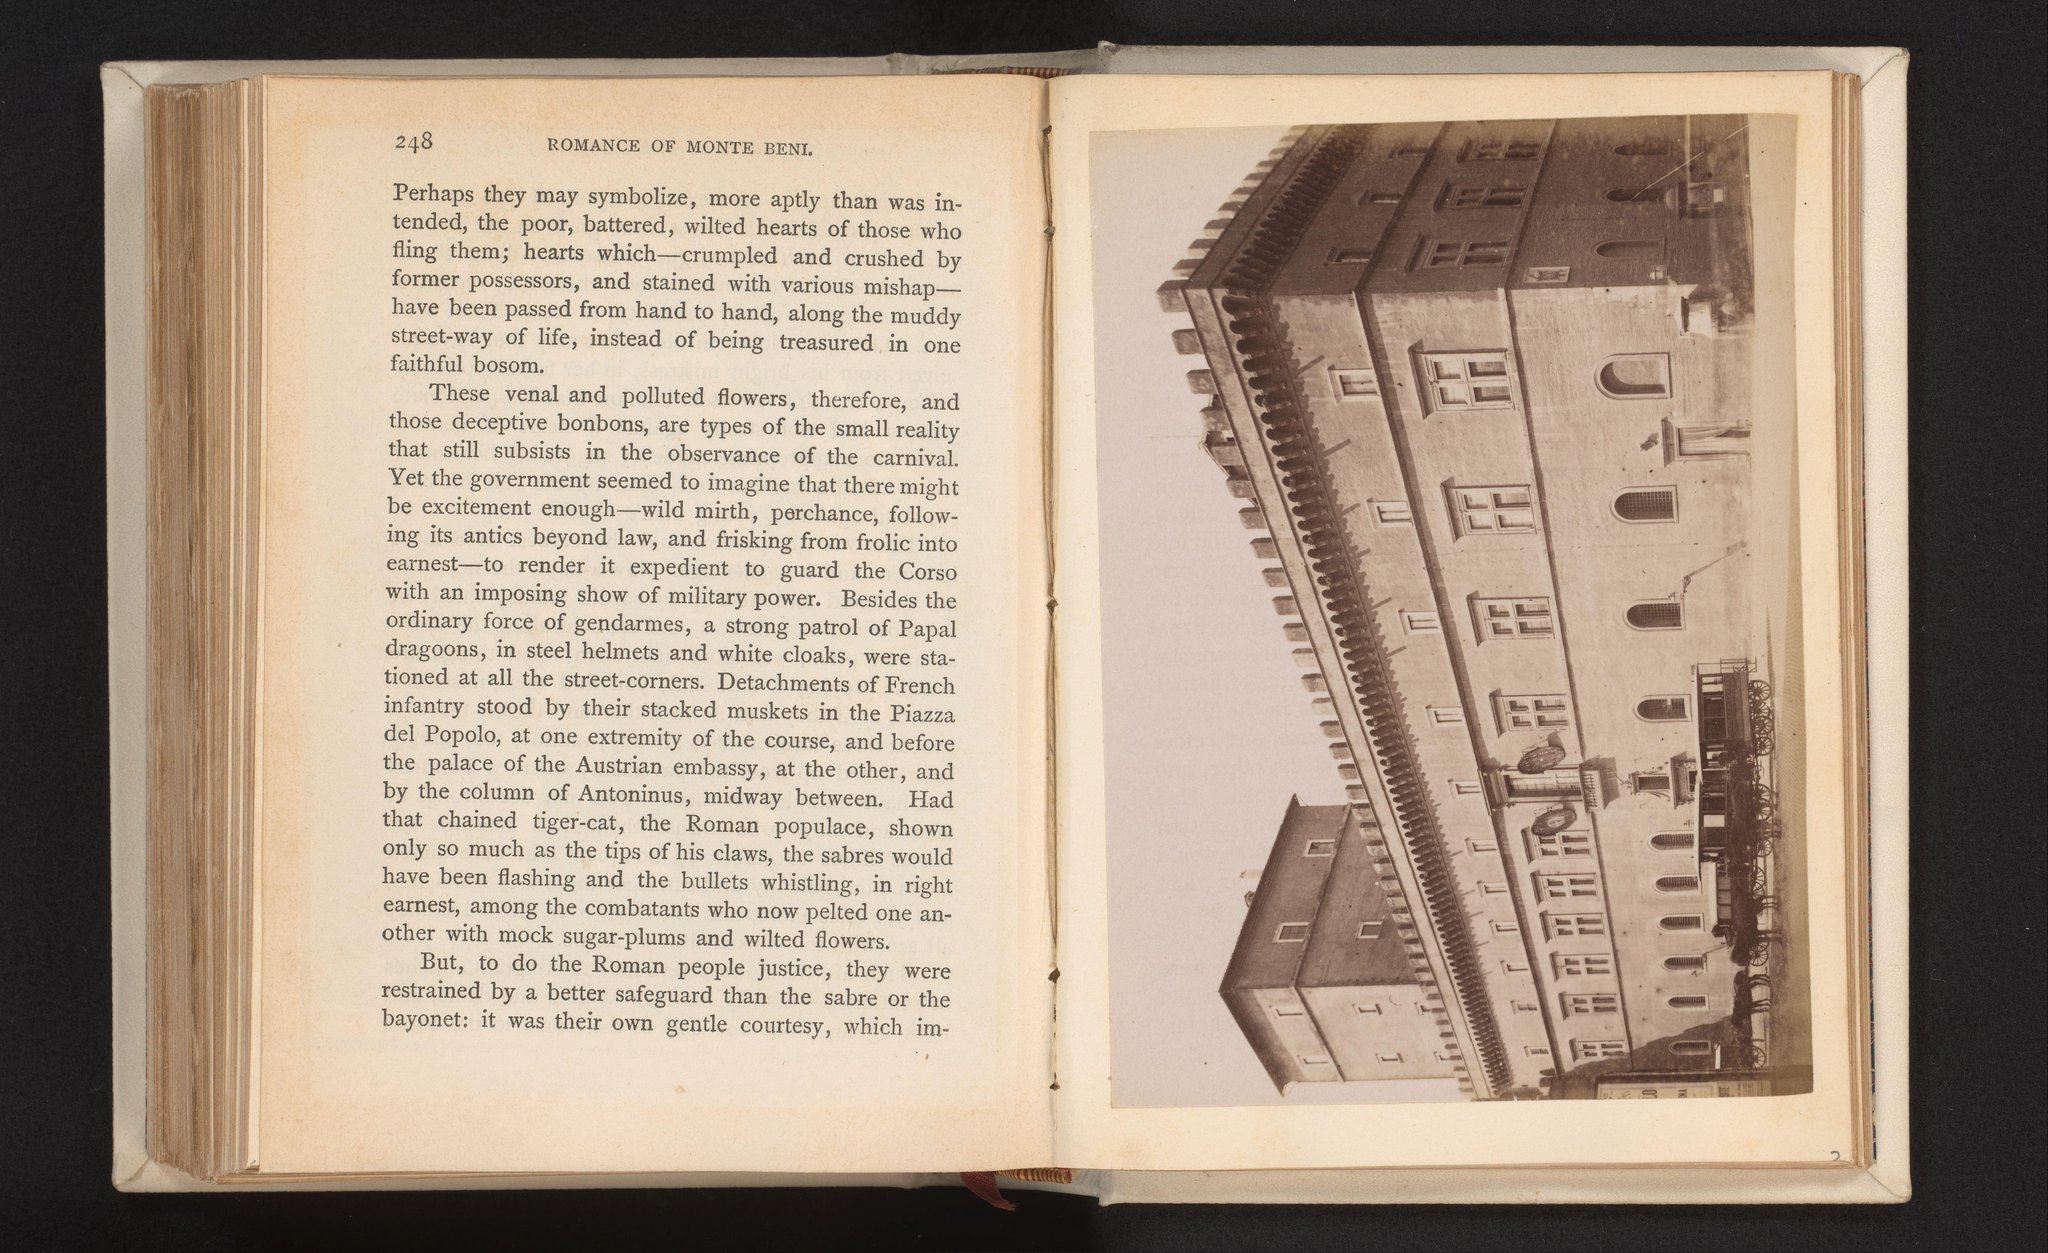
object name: page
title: Gezicht op een façade van vermoedelijk een paleis in Rome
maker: Anonymous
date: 1850-1860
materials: photographic support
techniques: albumen print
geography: rome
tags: façade (of house or building), rome